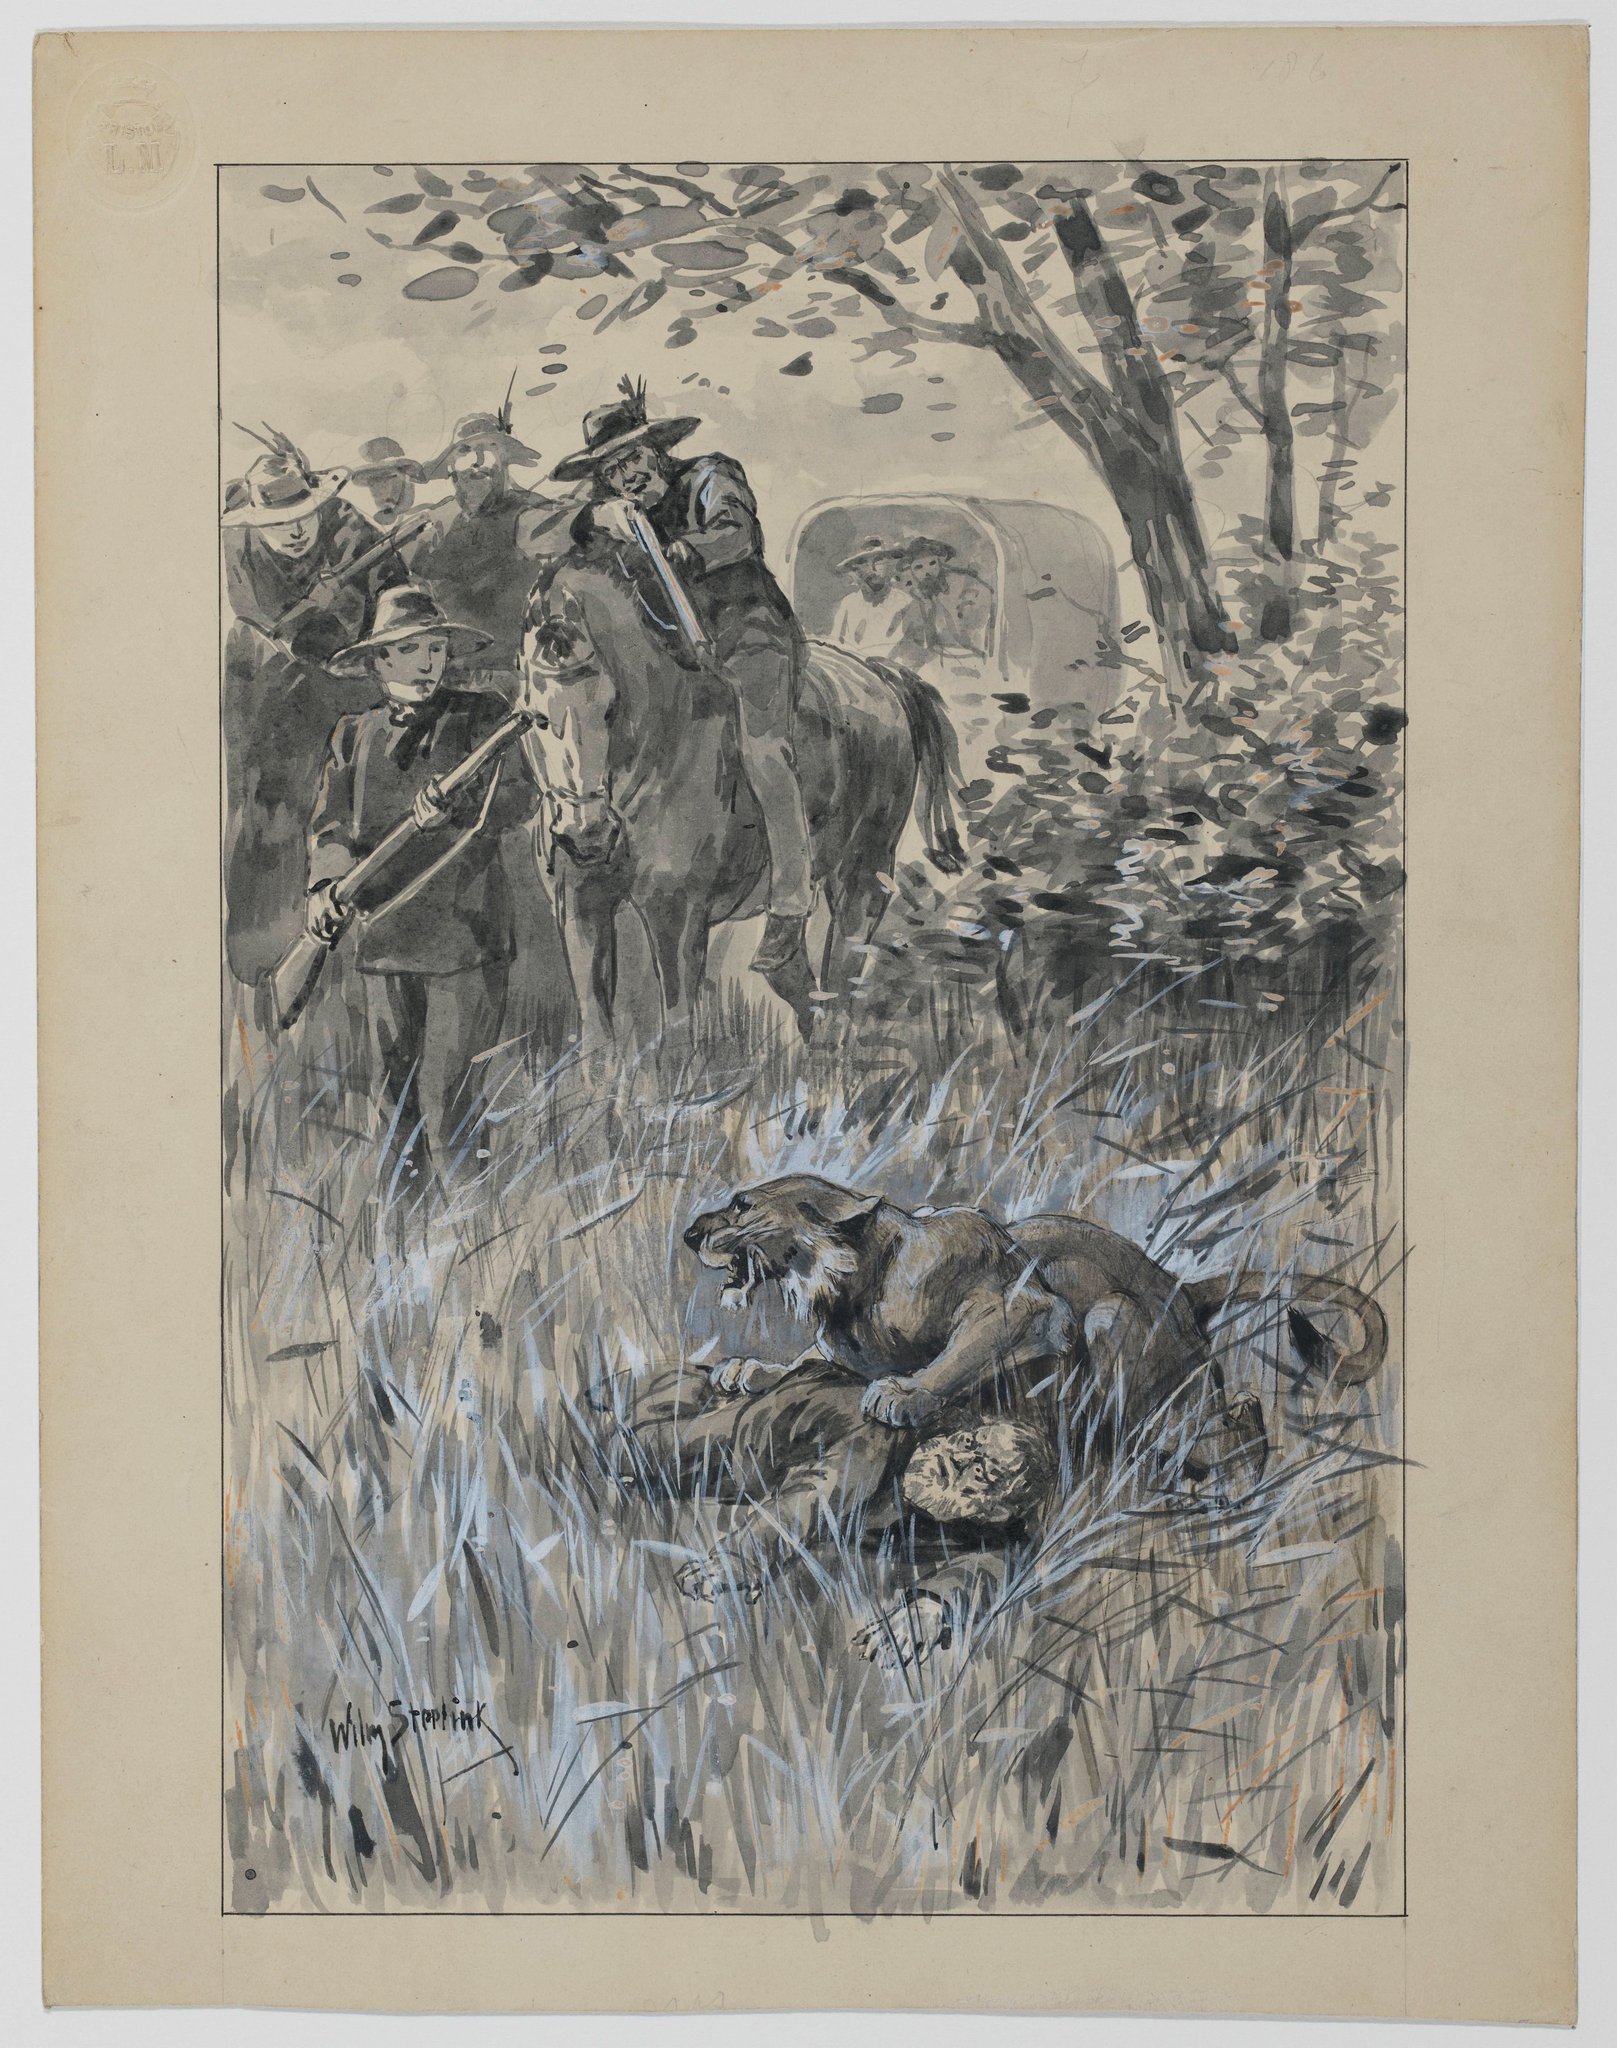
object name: drawing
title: Opgejaagde leeuw valt een man aan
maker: willem steelink (i)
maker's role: draughtsman, print maker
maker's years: 1826-1913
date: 1836-1913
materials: paper, pencil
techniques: brush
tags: hunted animal attacking man, illustration ~ printed matter, book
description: Ontwerp voor een illustratie in De Voortrekkers, of Het Dagboek van Izak van der Merwe, door J.D. Kestell en N. Hofmeijer.